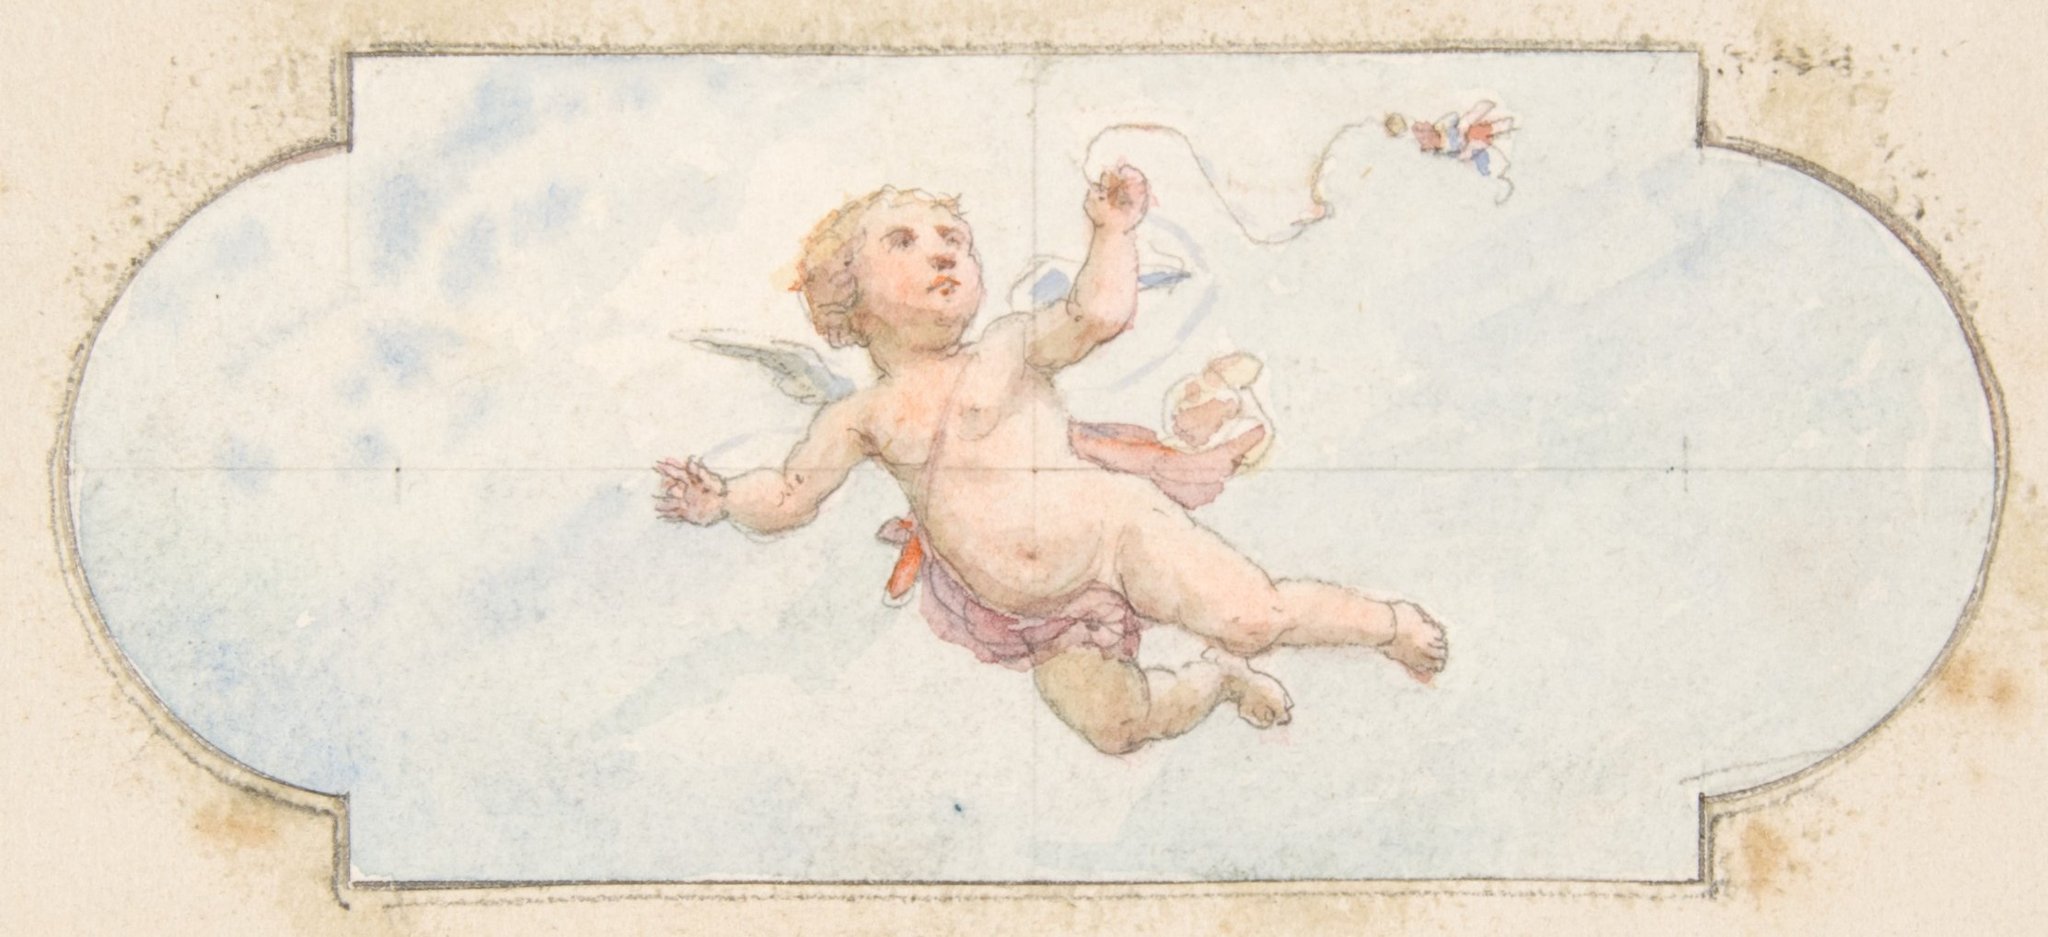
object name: drawing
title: A winged putto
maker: jules-edmond-charles lachaise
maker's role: artist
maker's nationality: french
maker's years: 1897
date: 1851-1900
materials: graphite, watercolor, paper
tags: putti